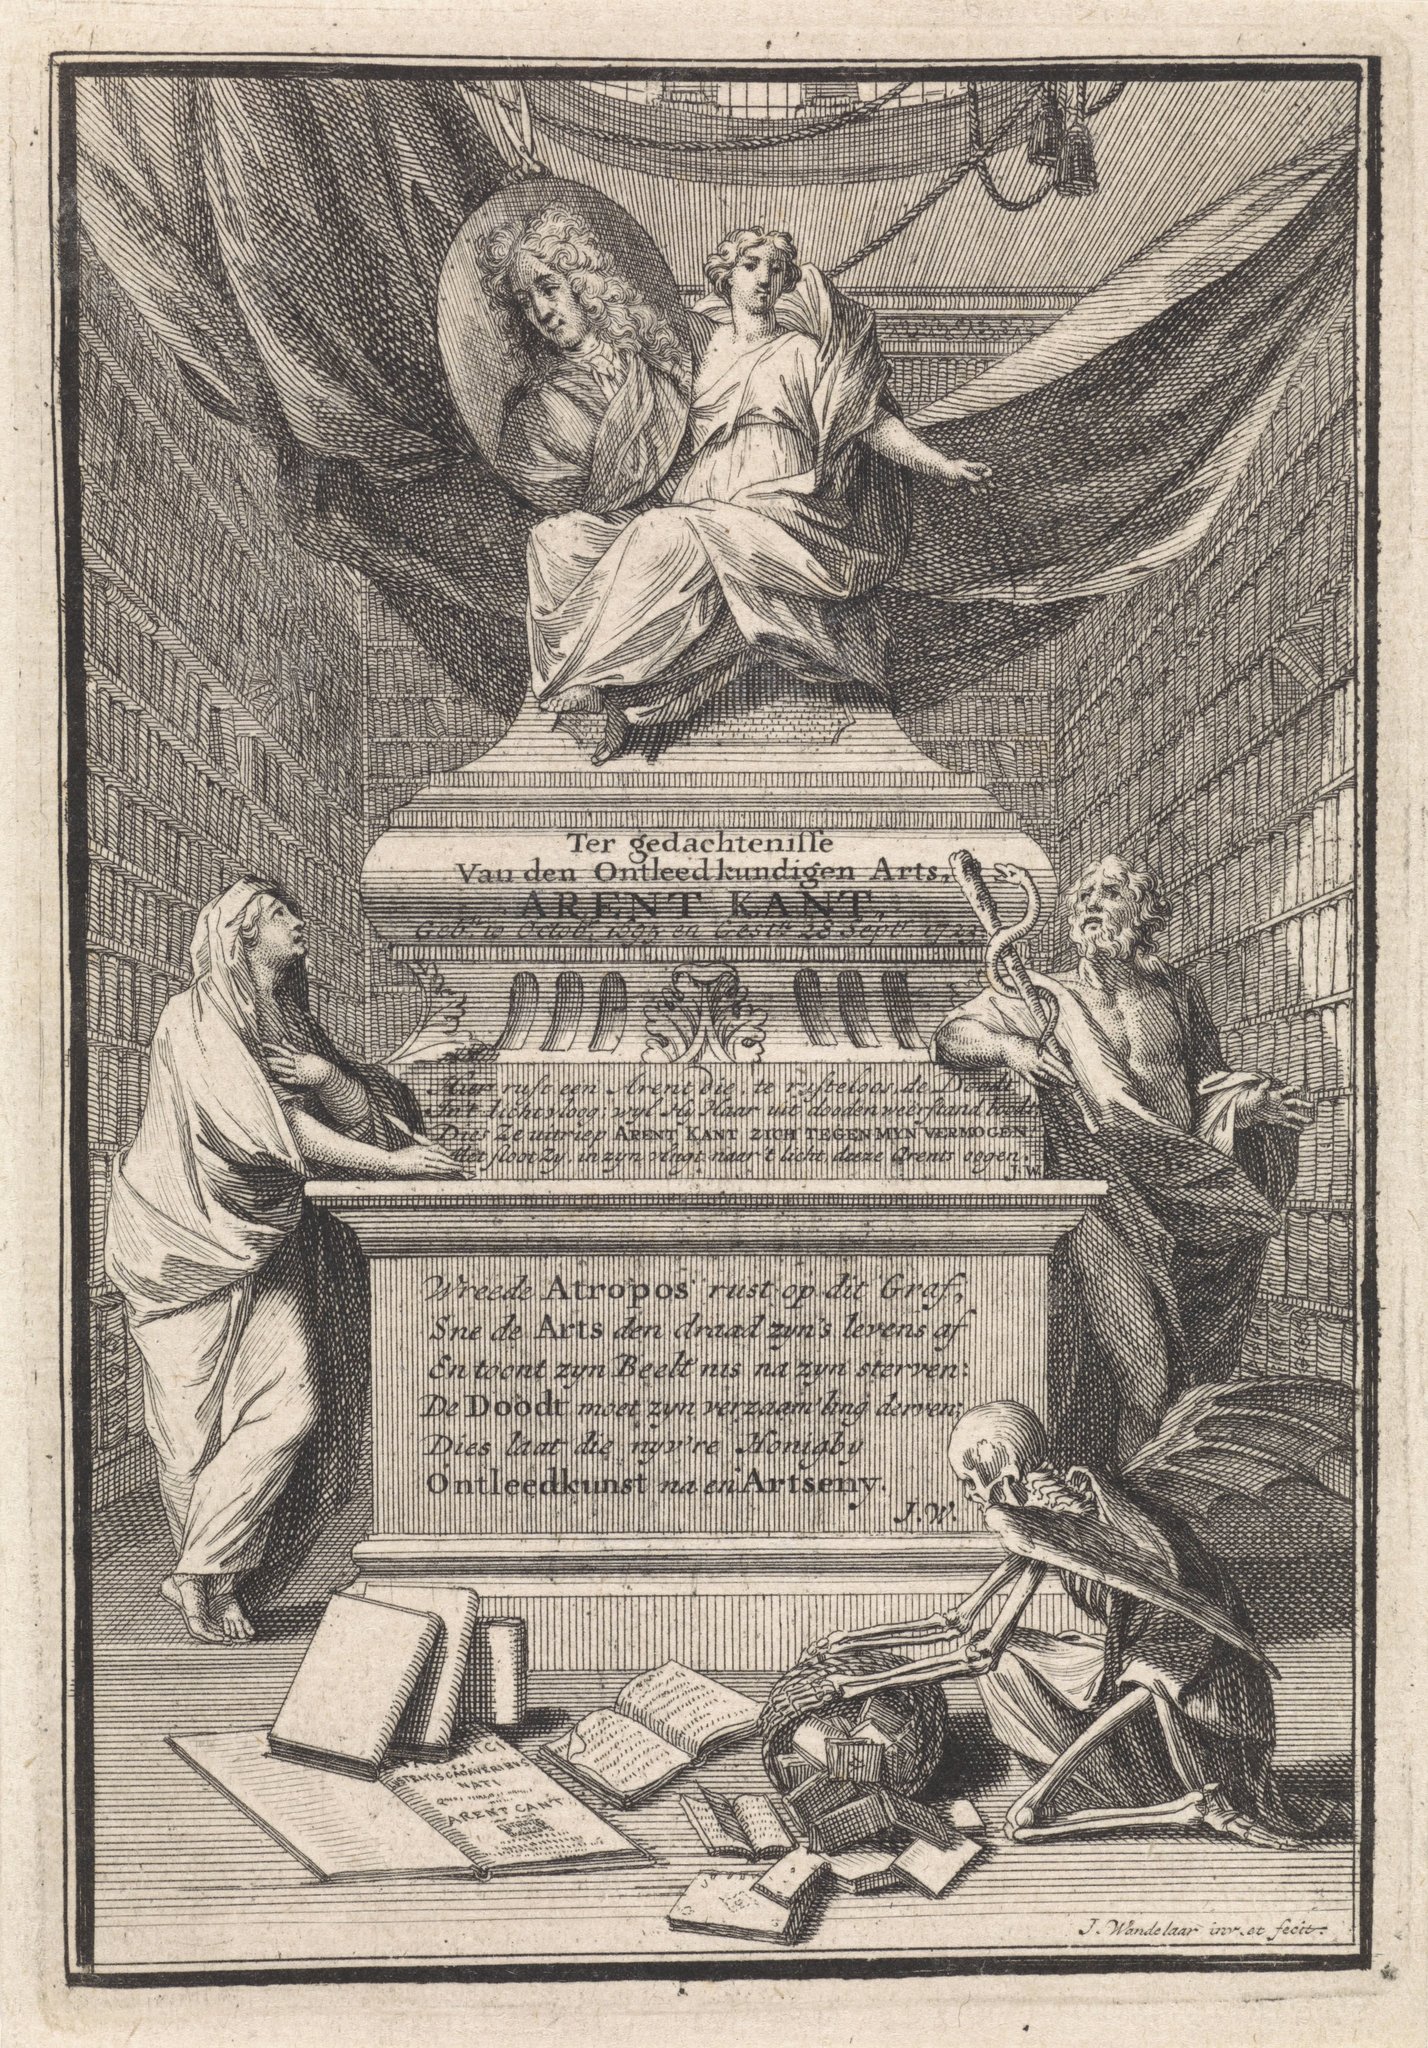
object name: print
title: Memorieprent voor Arent Cant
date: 1702-1759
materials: paper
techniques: engraving, etching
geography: northern netherlands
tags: death as skeleton, grave, tomb, study; 'studiolo'; library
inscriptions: collector's mark: Lugt 240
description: Prent ter nagedachtenis aan de anatoom Arent Cant. In het interieur van een bibliotheek staat een graftombe, bekroond met een allegorische vrouwfiguur die het portret van Cant vasthoudt. Op de tombe, geflankeerd door allegorische figuren, twee gedichten in het Nederlands. Op de voorgrond de Dood als gevleugeld skelet, die een mand met boeken leeg haalt.